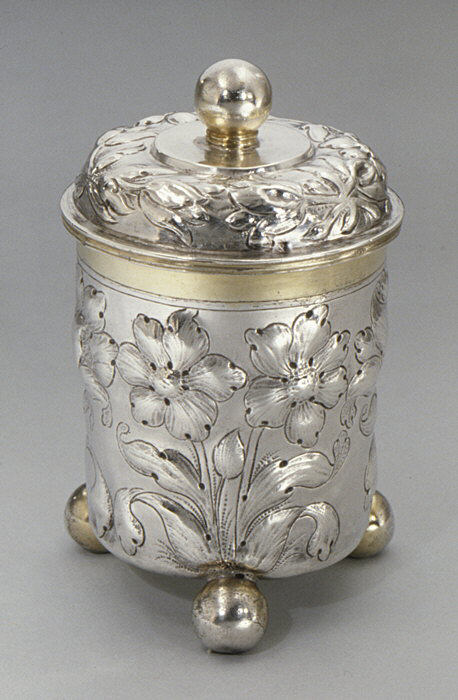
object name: beaker with cover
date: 1651-1700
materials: gilt, silver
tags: flowers